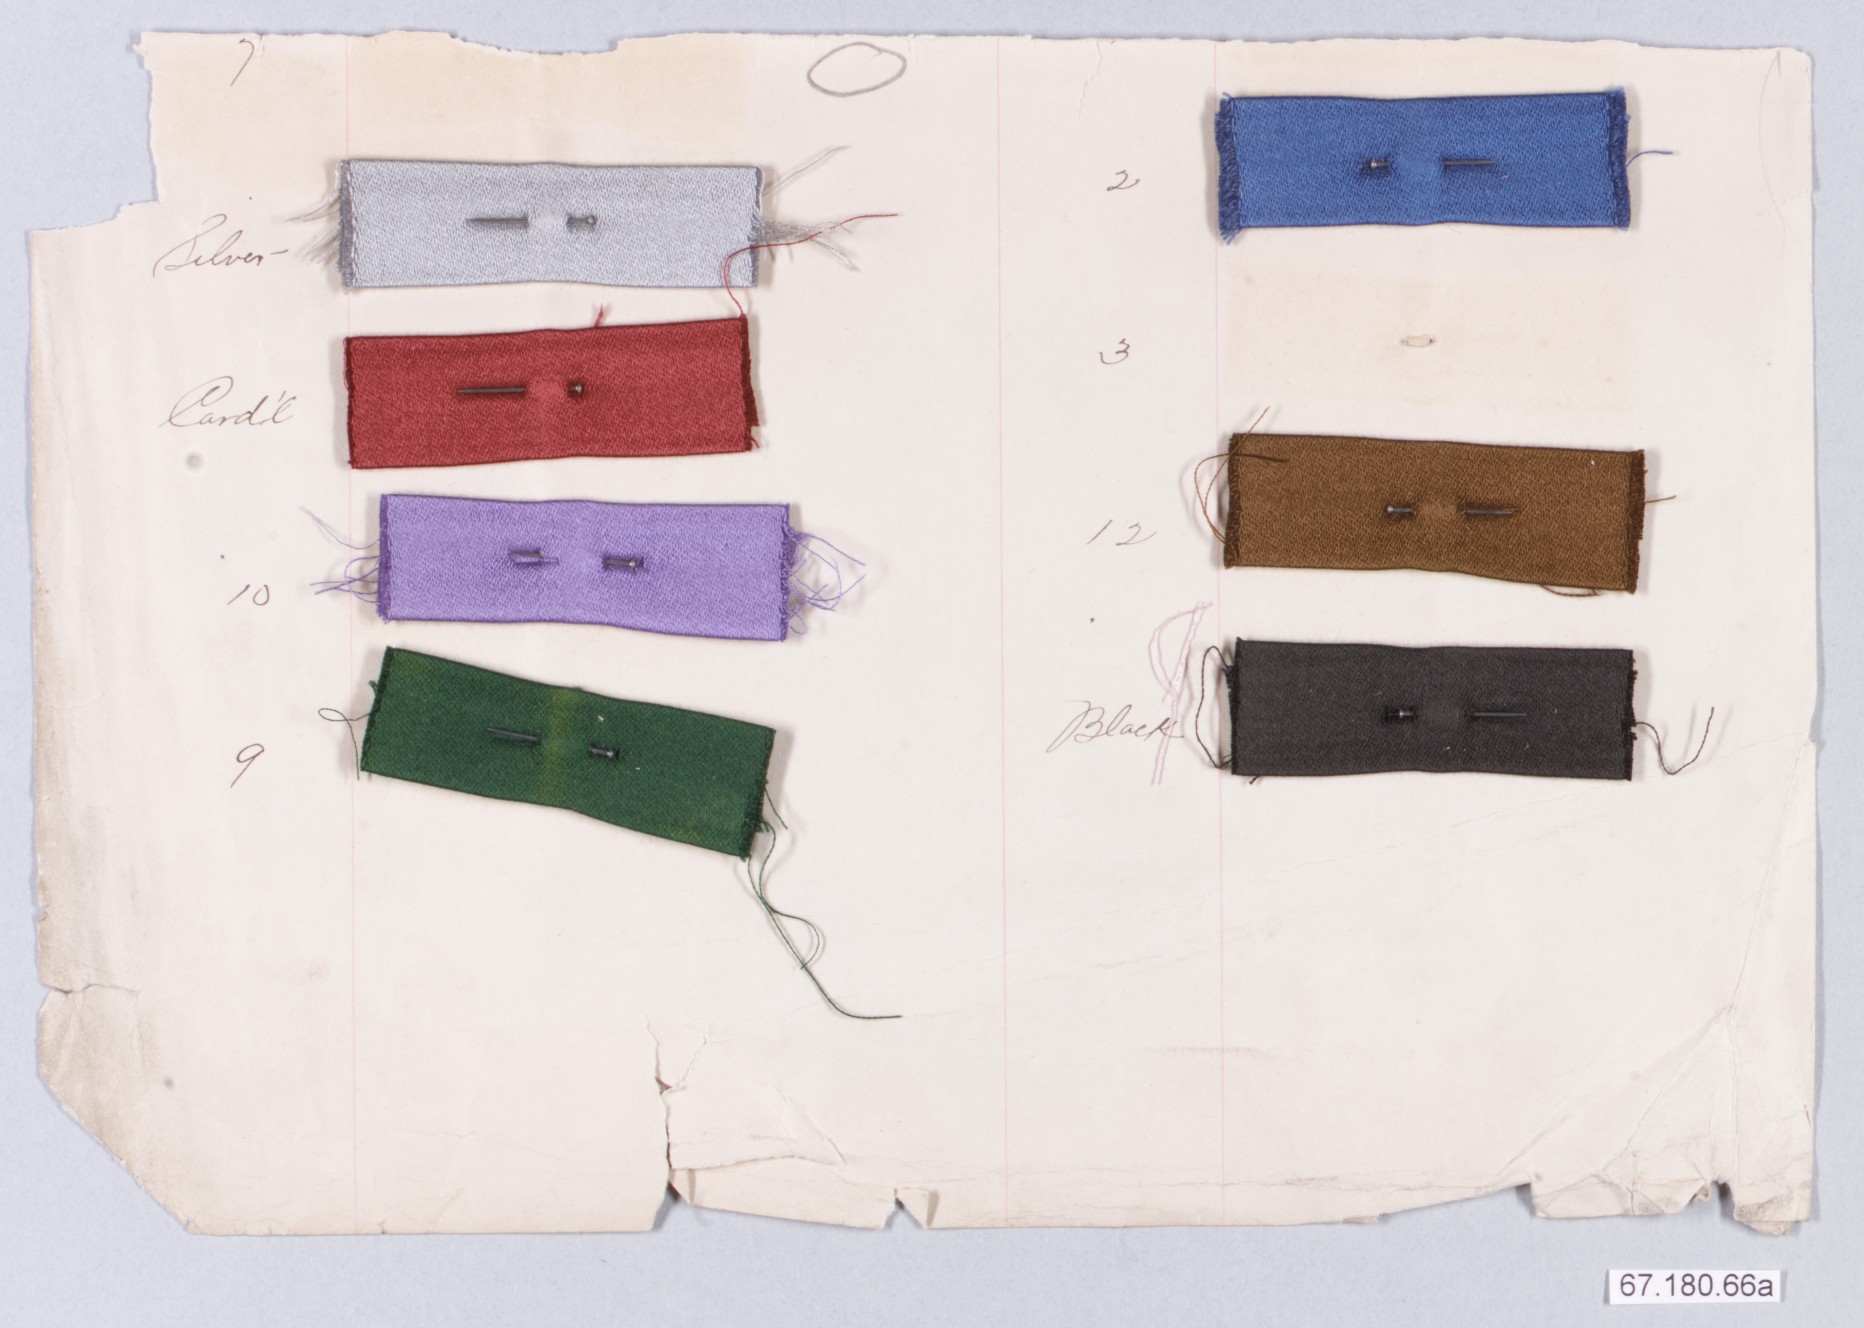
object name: sample book page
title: Sample book, page from a sample book and loose samples (in envelope)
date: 1840